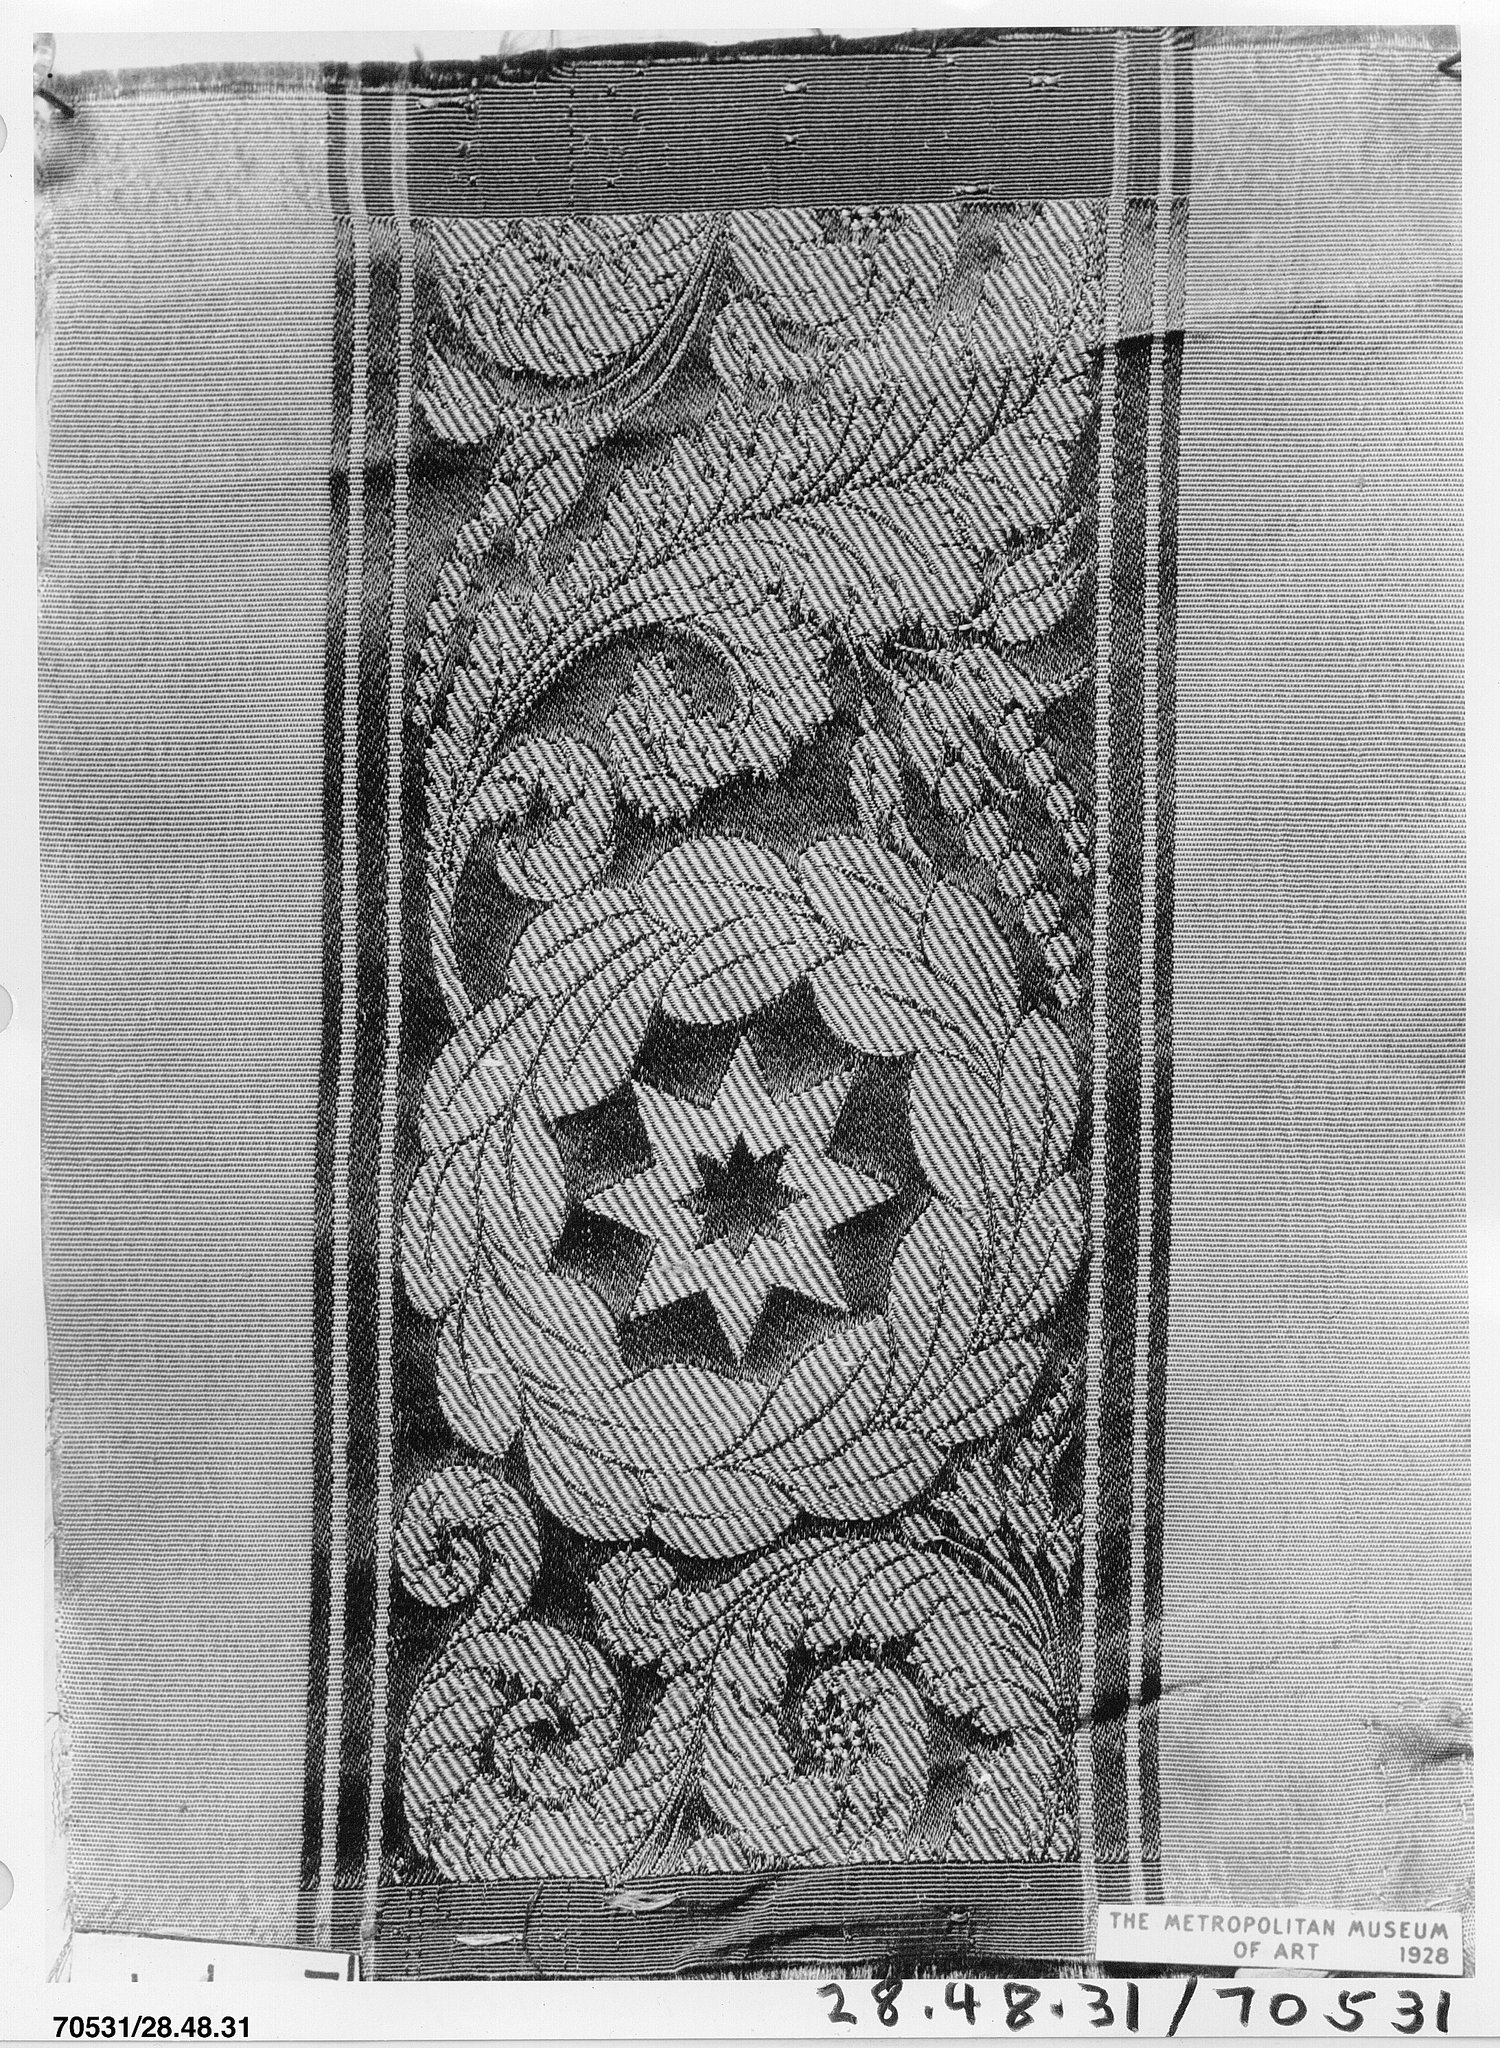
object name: border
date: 1801-1900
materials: silk